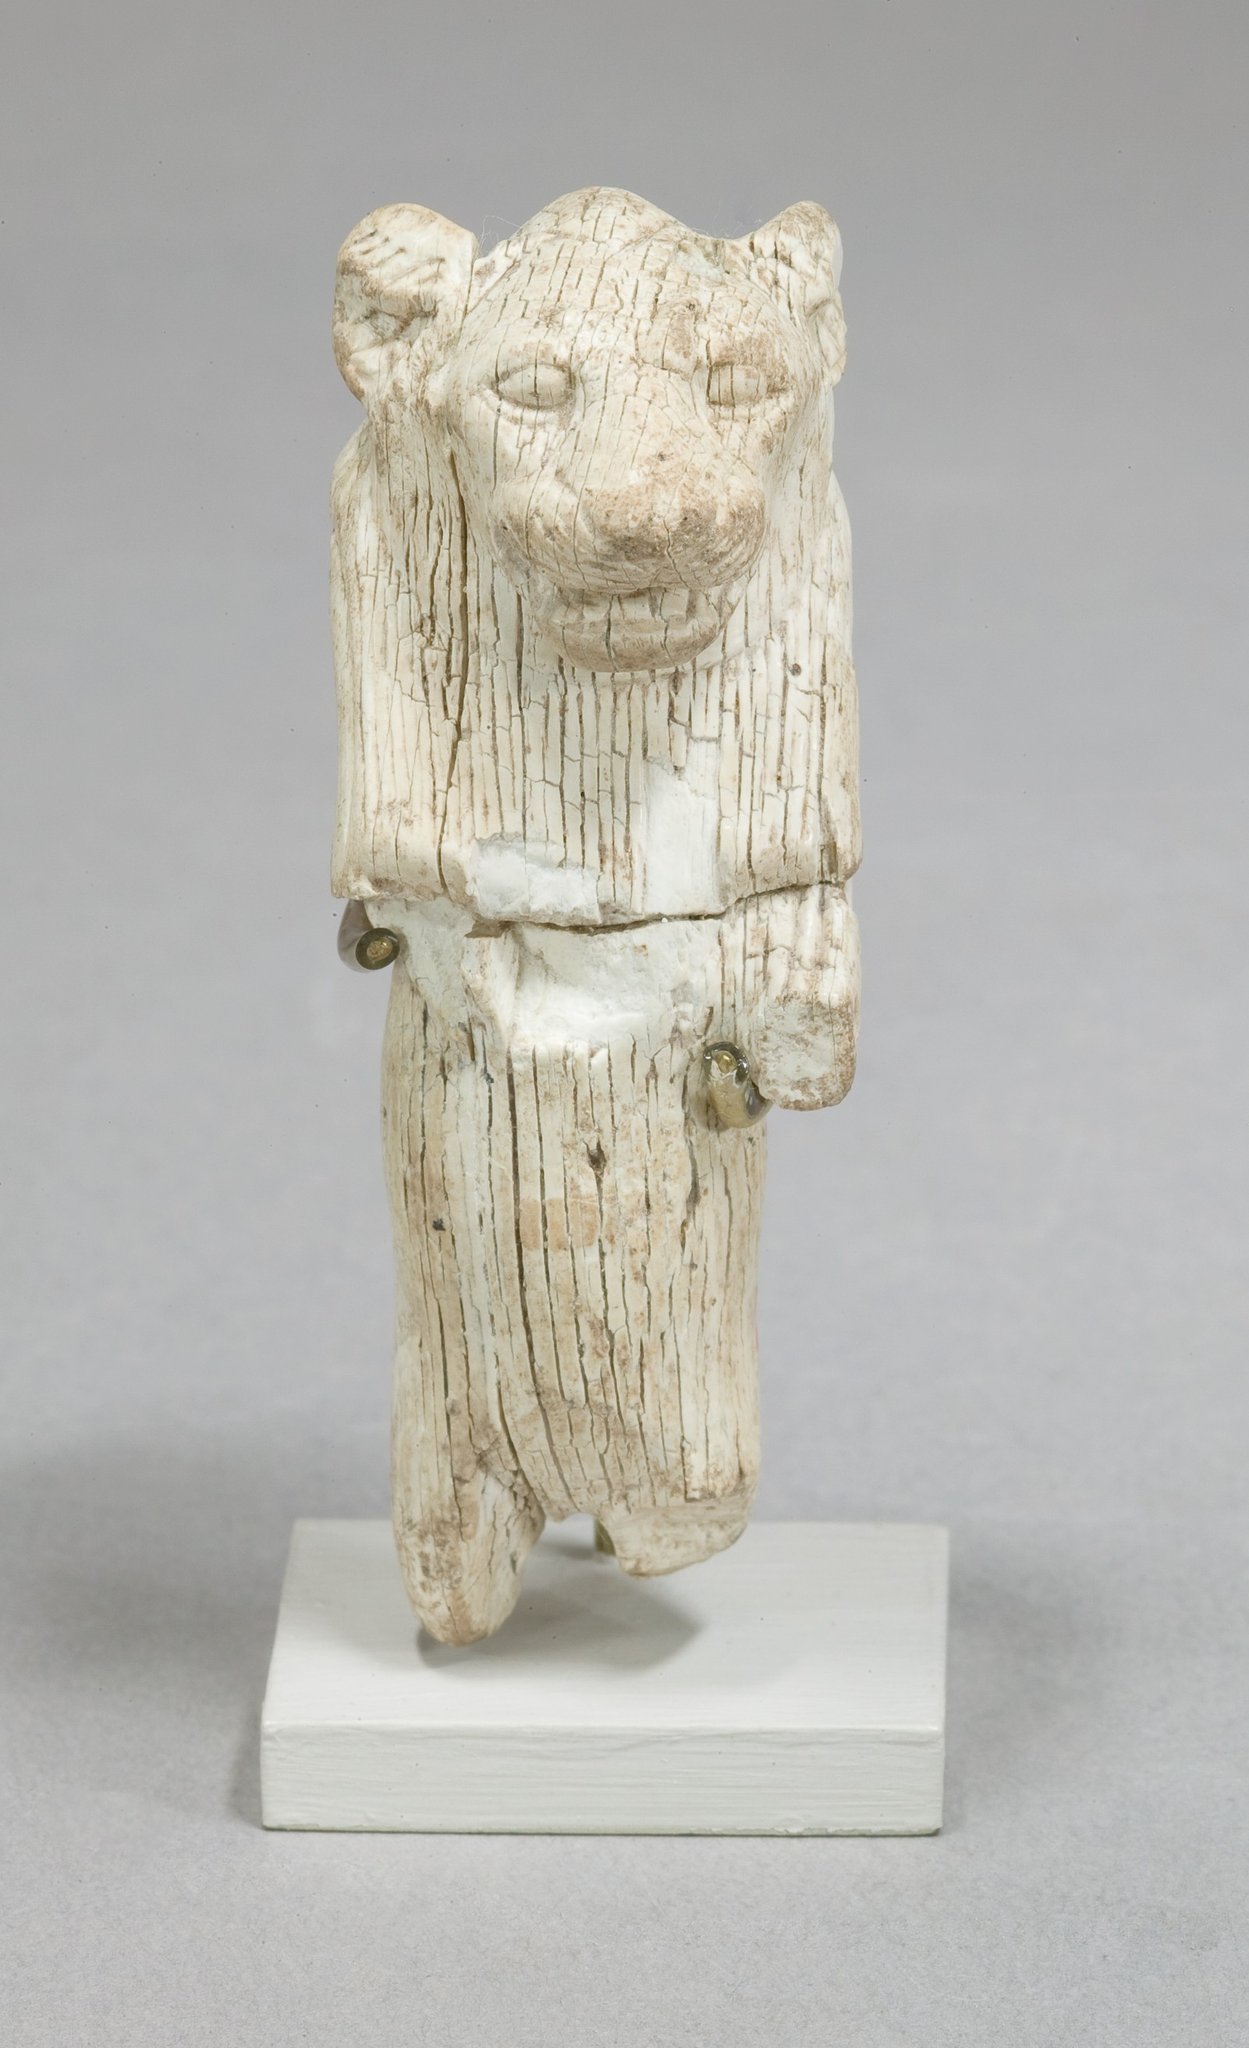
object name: figurine, lion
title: Figure of lion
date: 1850-1700 BCE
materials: ivory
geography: egypt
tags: lions